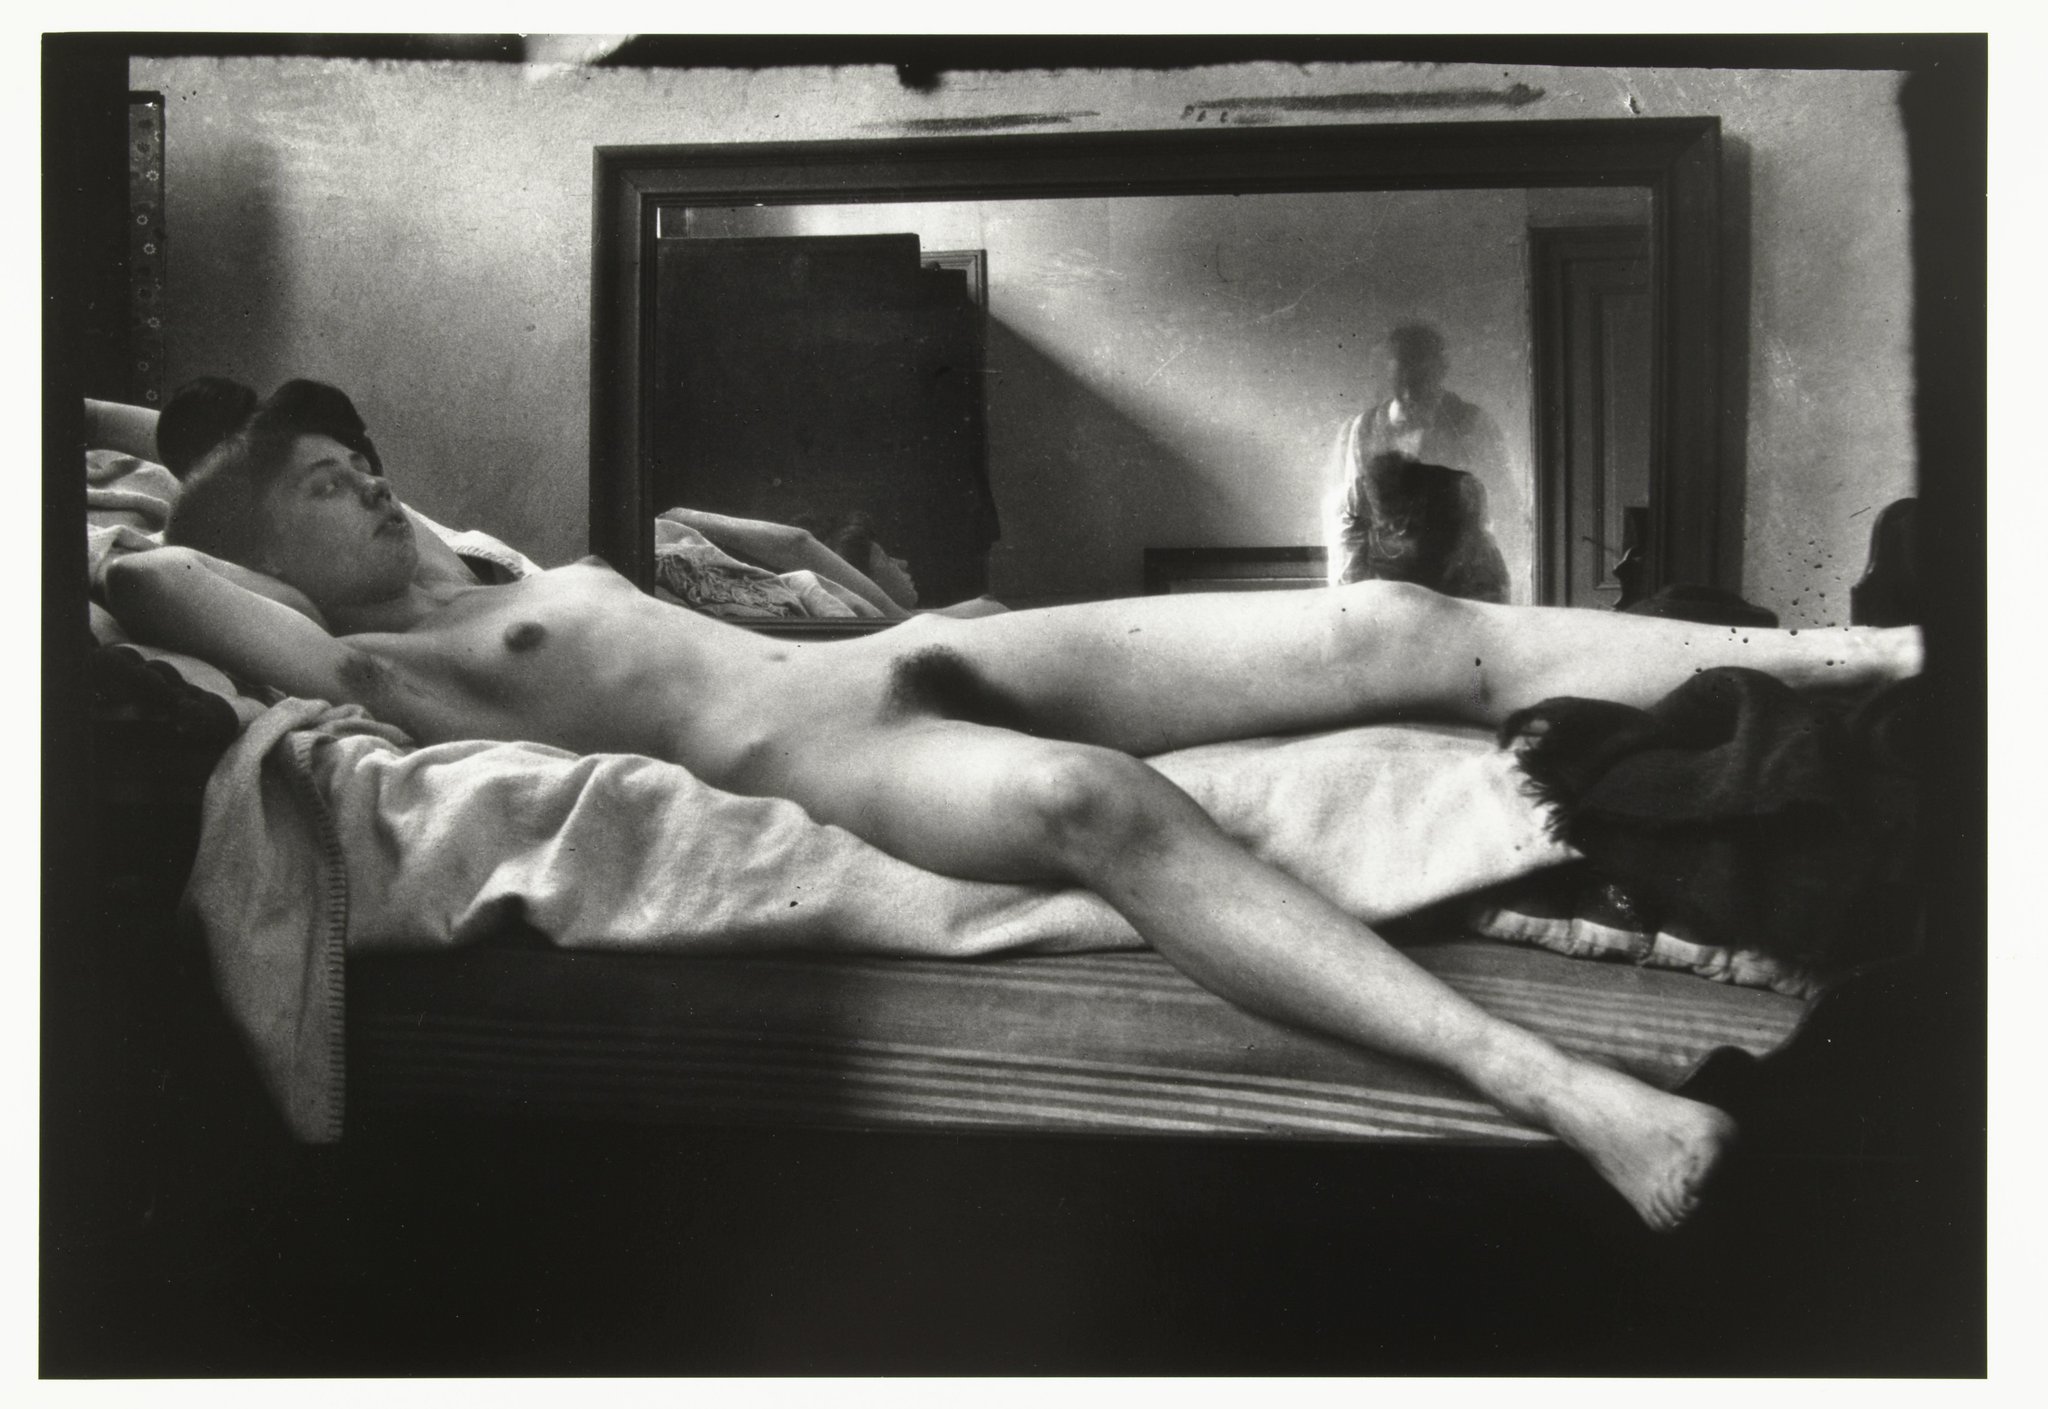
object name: photograph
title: Portret van een vrouwelijk naakt met in de spiegel de fotograferende Breitner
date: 1890-1910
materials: paper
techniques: gelatin silver print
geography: netherlands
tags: rotterdam, print maker, george hendrik breitner, the (nude) human figure; 'corpo humano' (ripa) - aa - female human figure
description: Moderne afdruk van negatief BR 911 (collectie RKD).